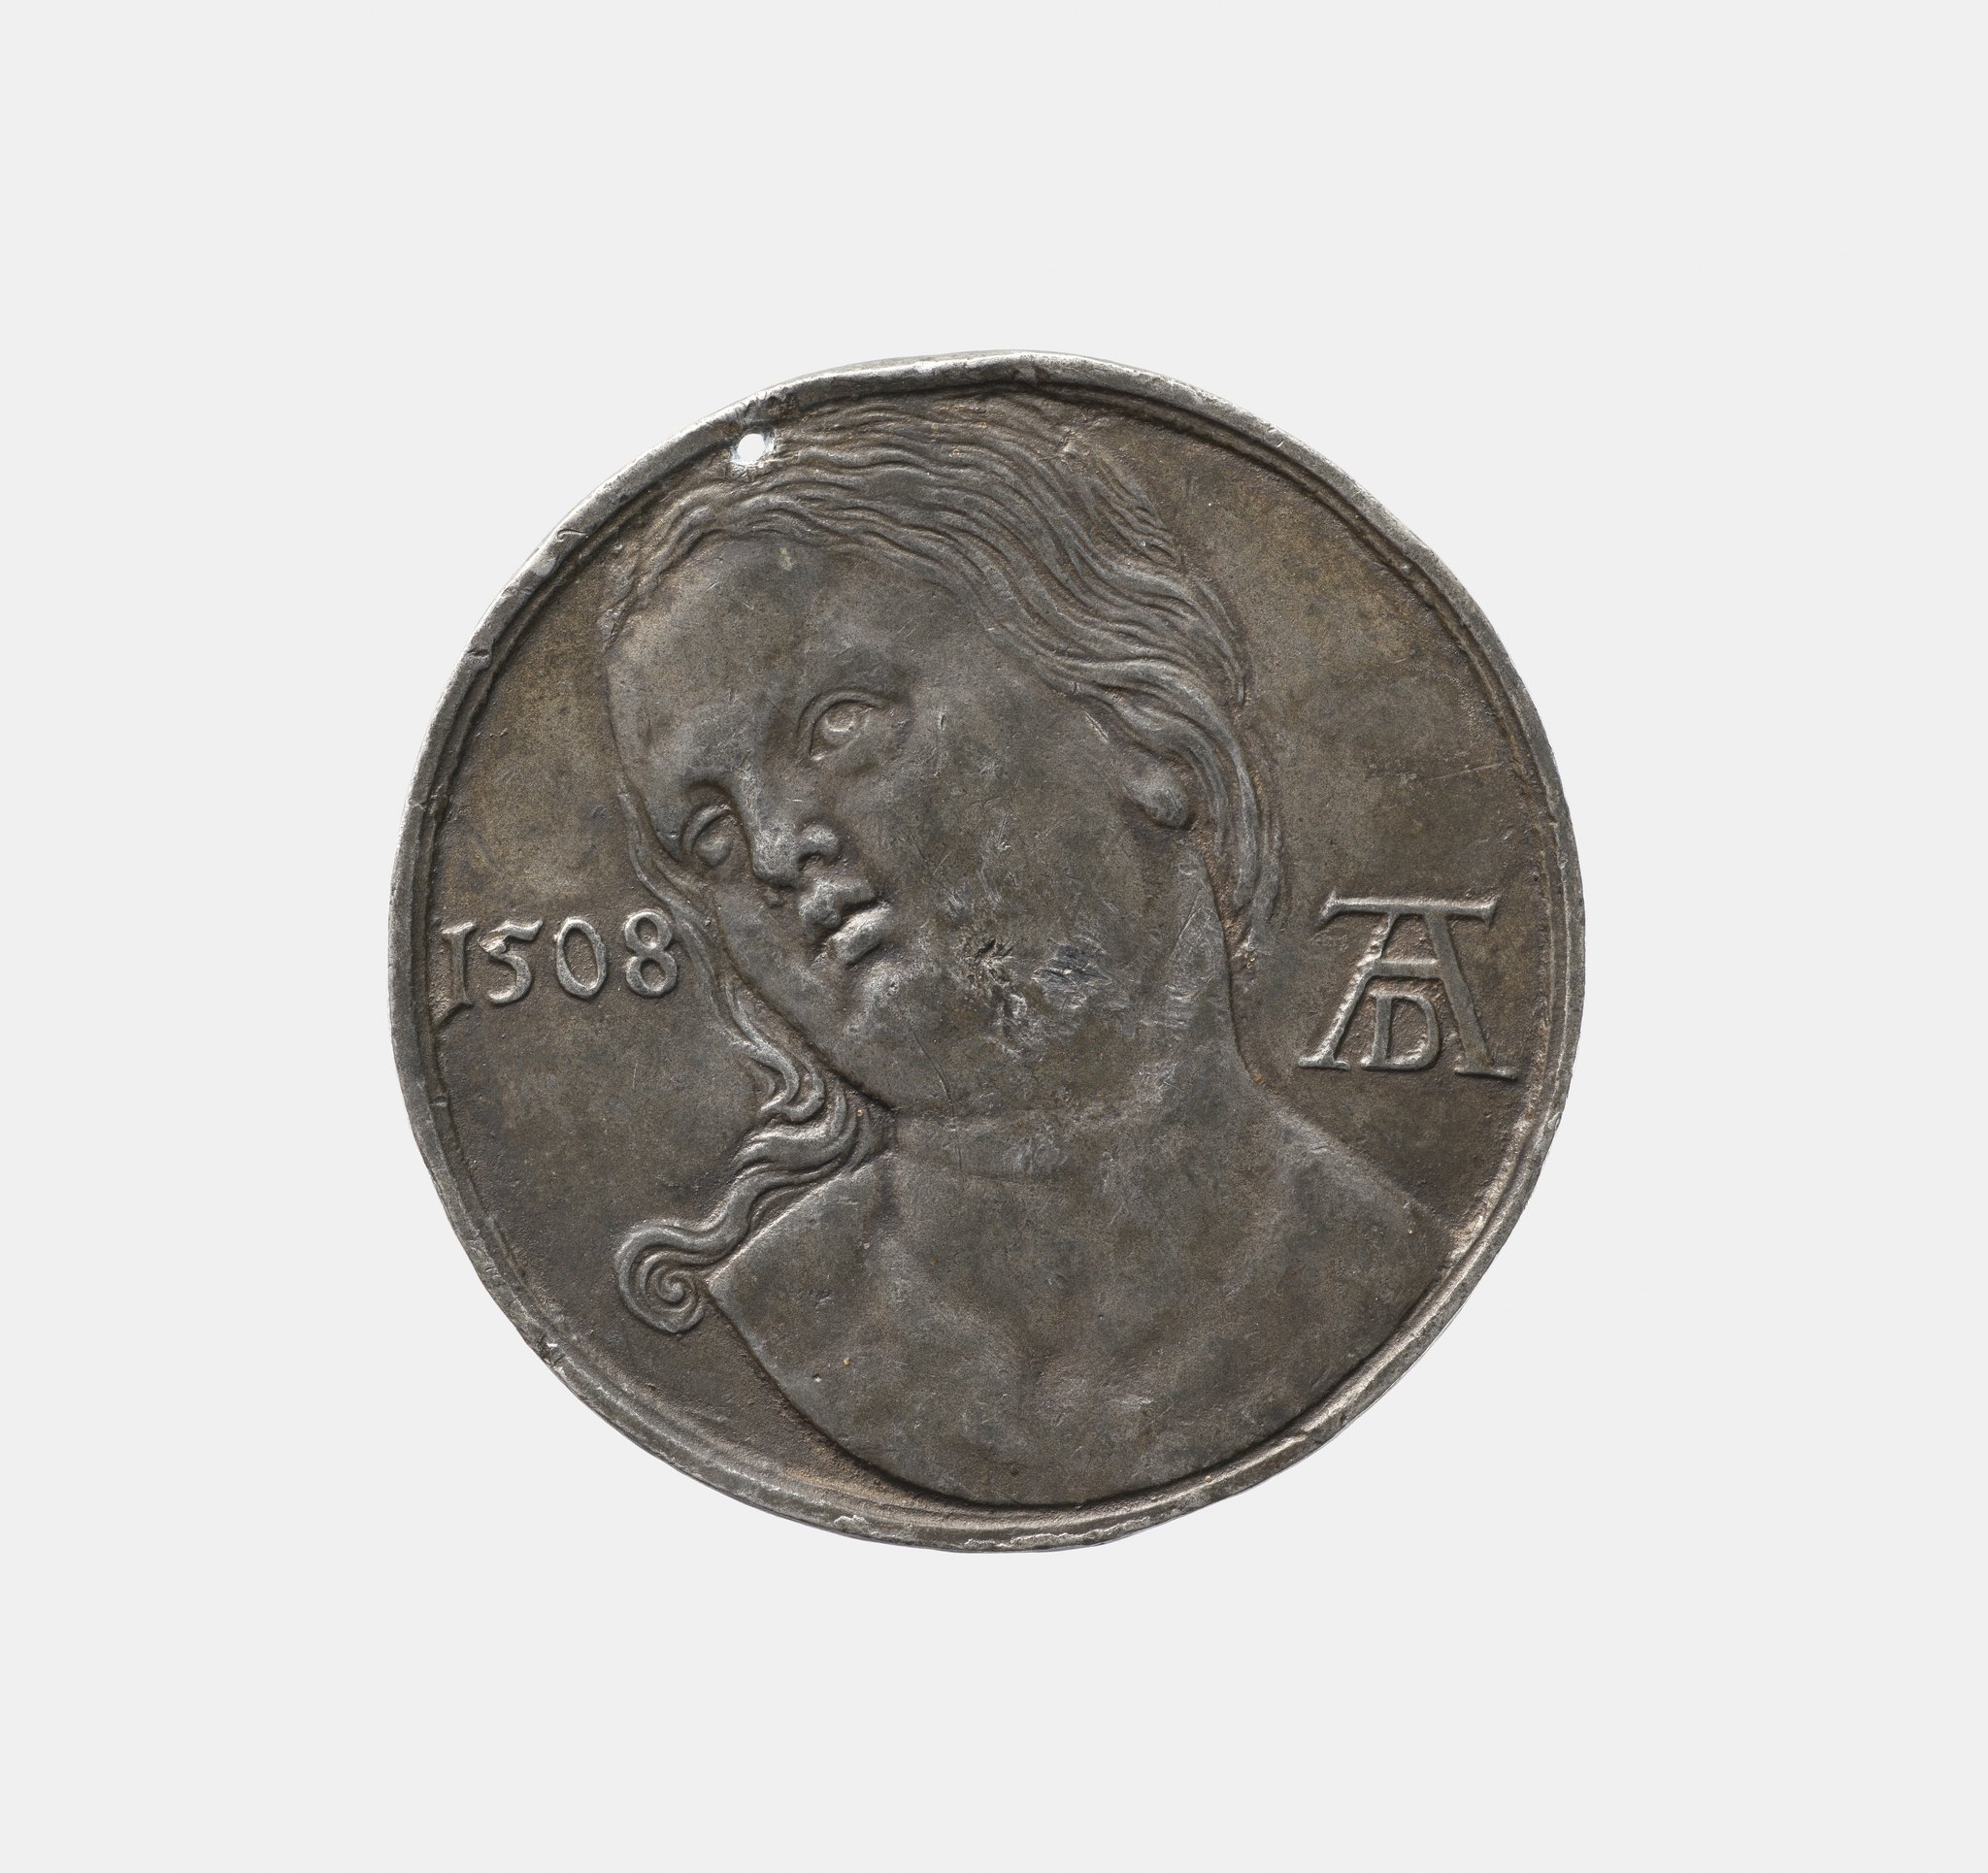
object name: medal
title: Lucretia, formerly described as Agnes Dürer, the artist's wife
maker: albrecht dürer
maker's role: artist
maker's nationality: german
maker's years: 1471-1528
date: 1508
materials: lead